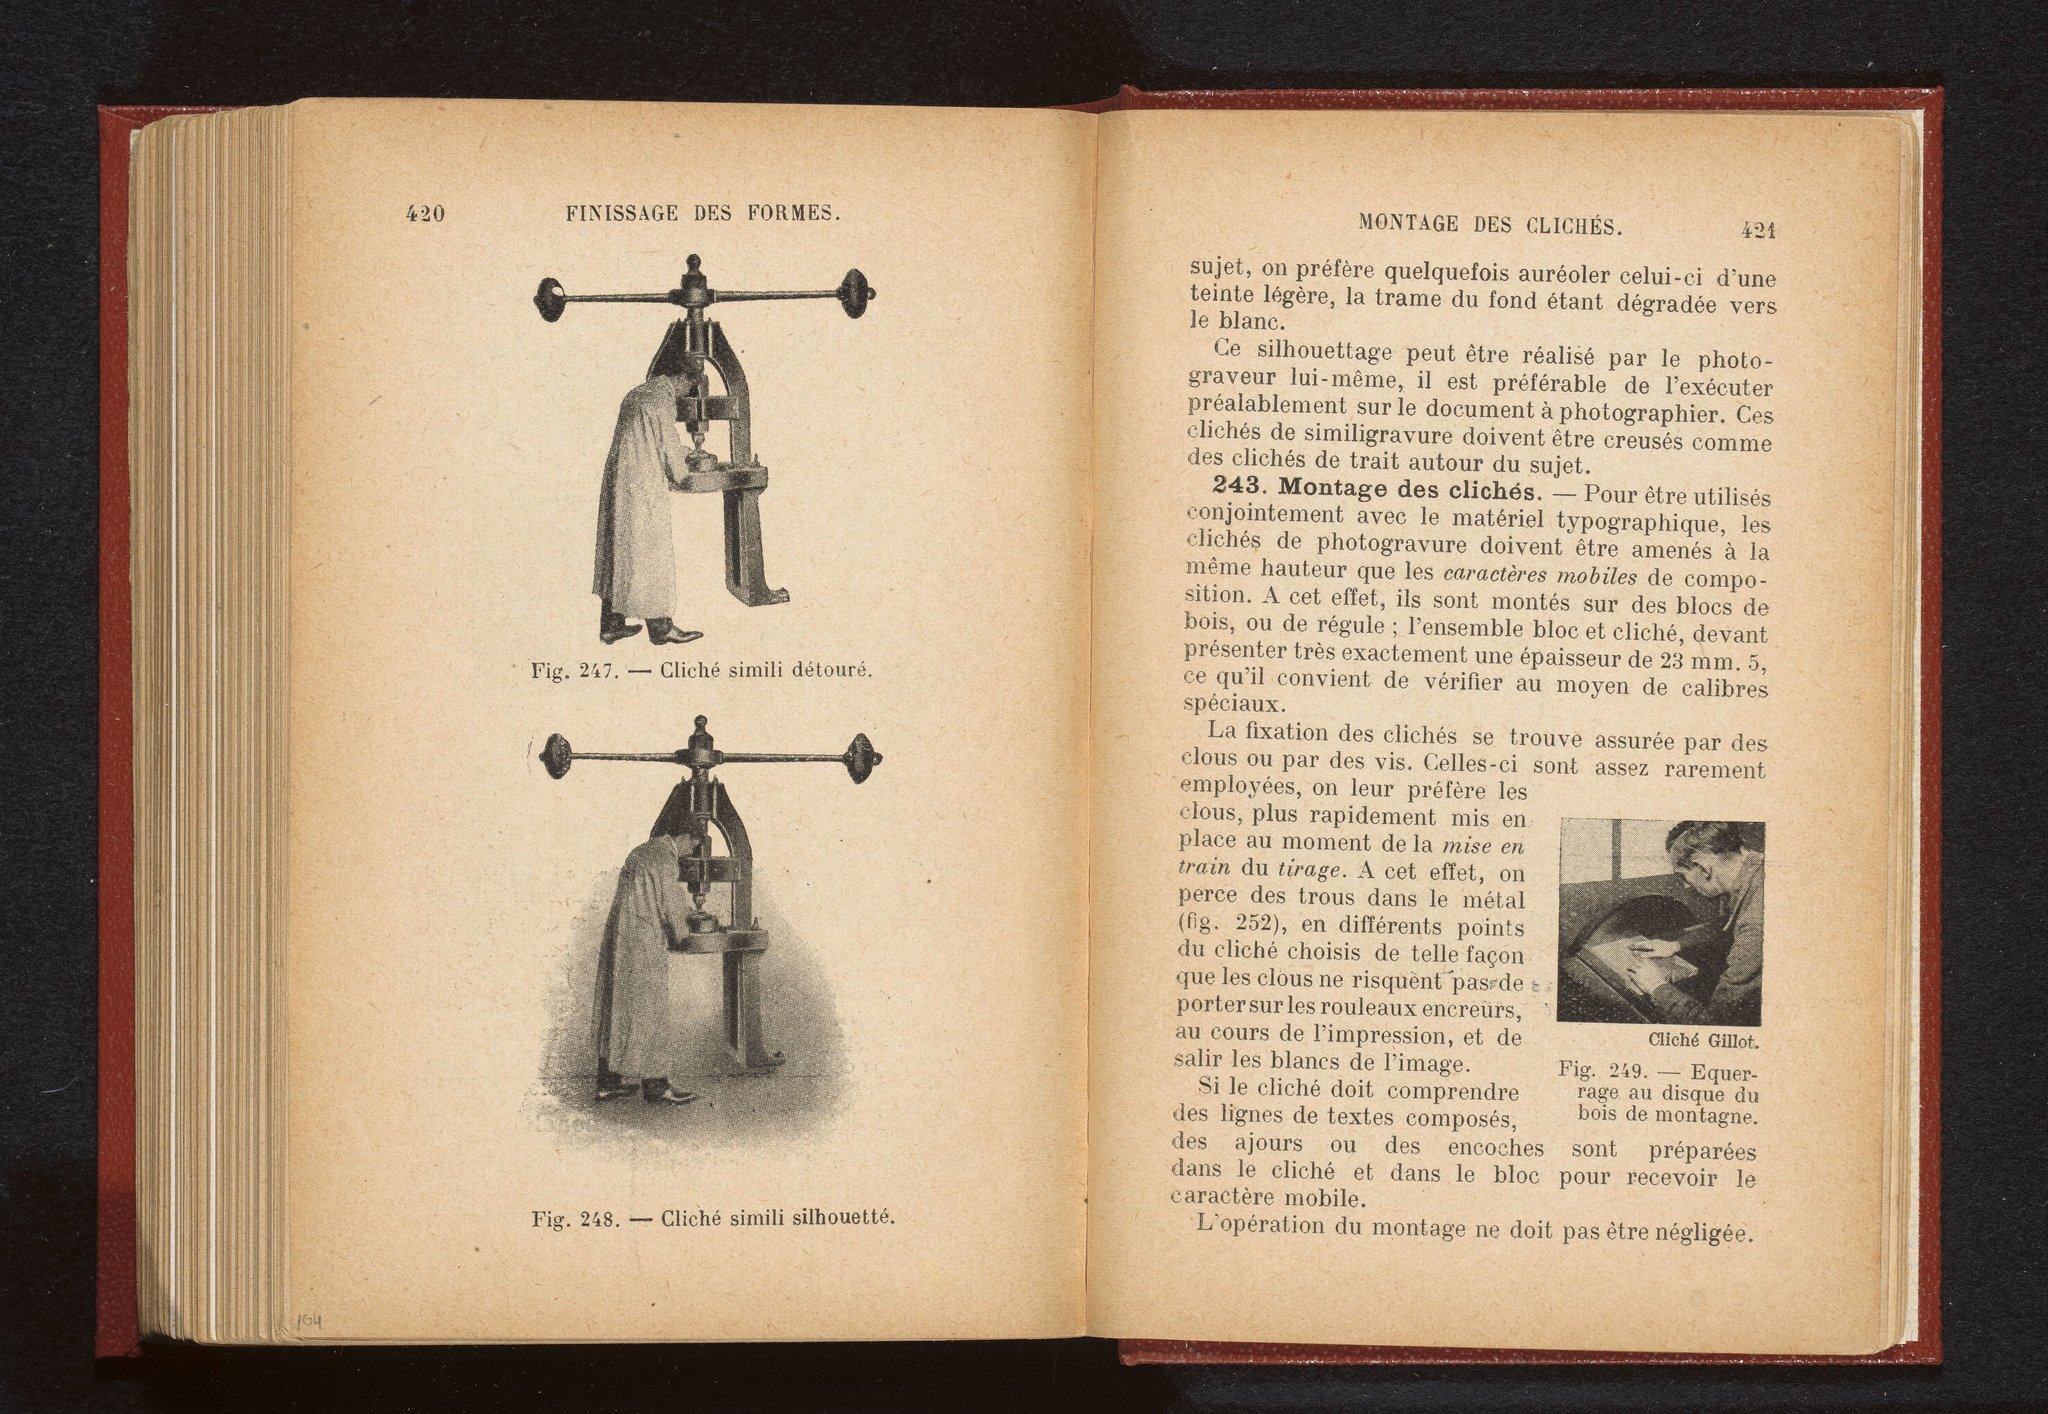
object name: photomechanical print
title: Man die een houten schijf bewerkt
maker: Anonymous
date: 1922-1932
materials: paper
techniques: autotype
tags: printing, printing office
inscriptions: number: ‘Fig. 249.’